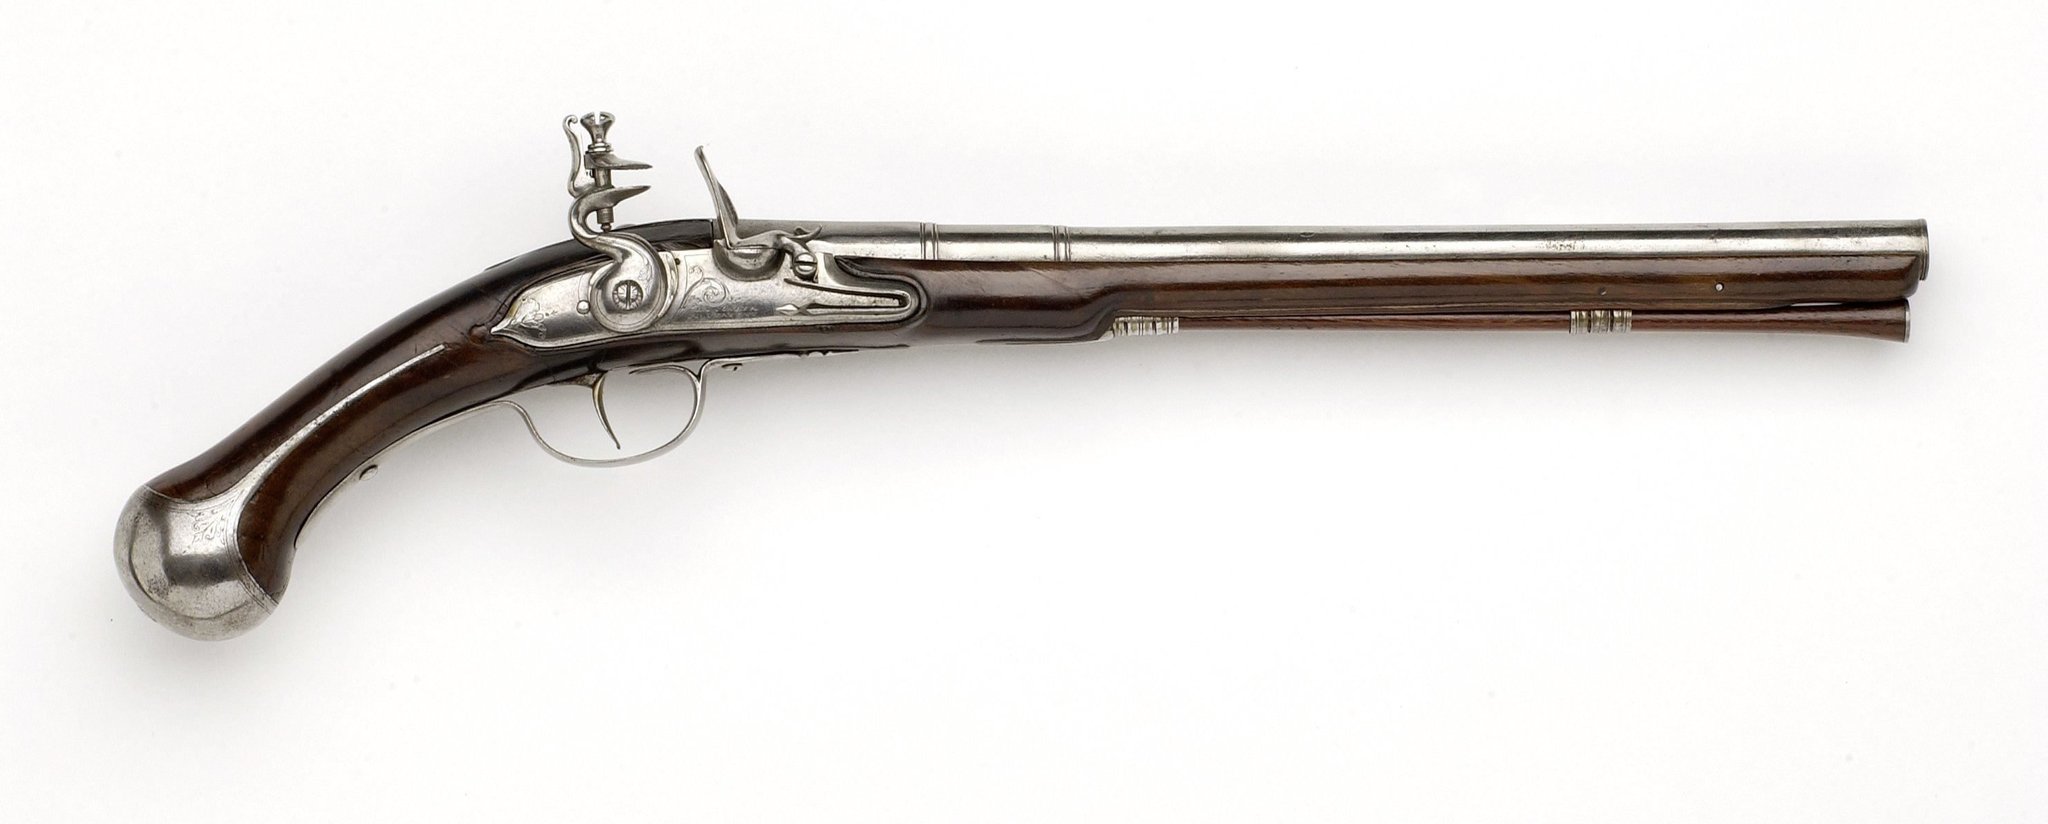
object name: flintlock pistol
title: Vuursteenpistool met gordelhaak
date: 1680-1690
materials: iron, wood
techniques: engraving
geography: utrecht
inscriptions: inscription: ‘LASONDER // A. UTRECHT’, coat of arms: ‘C’